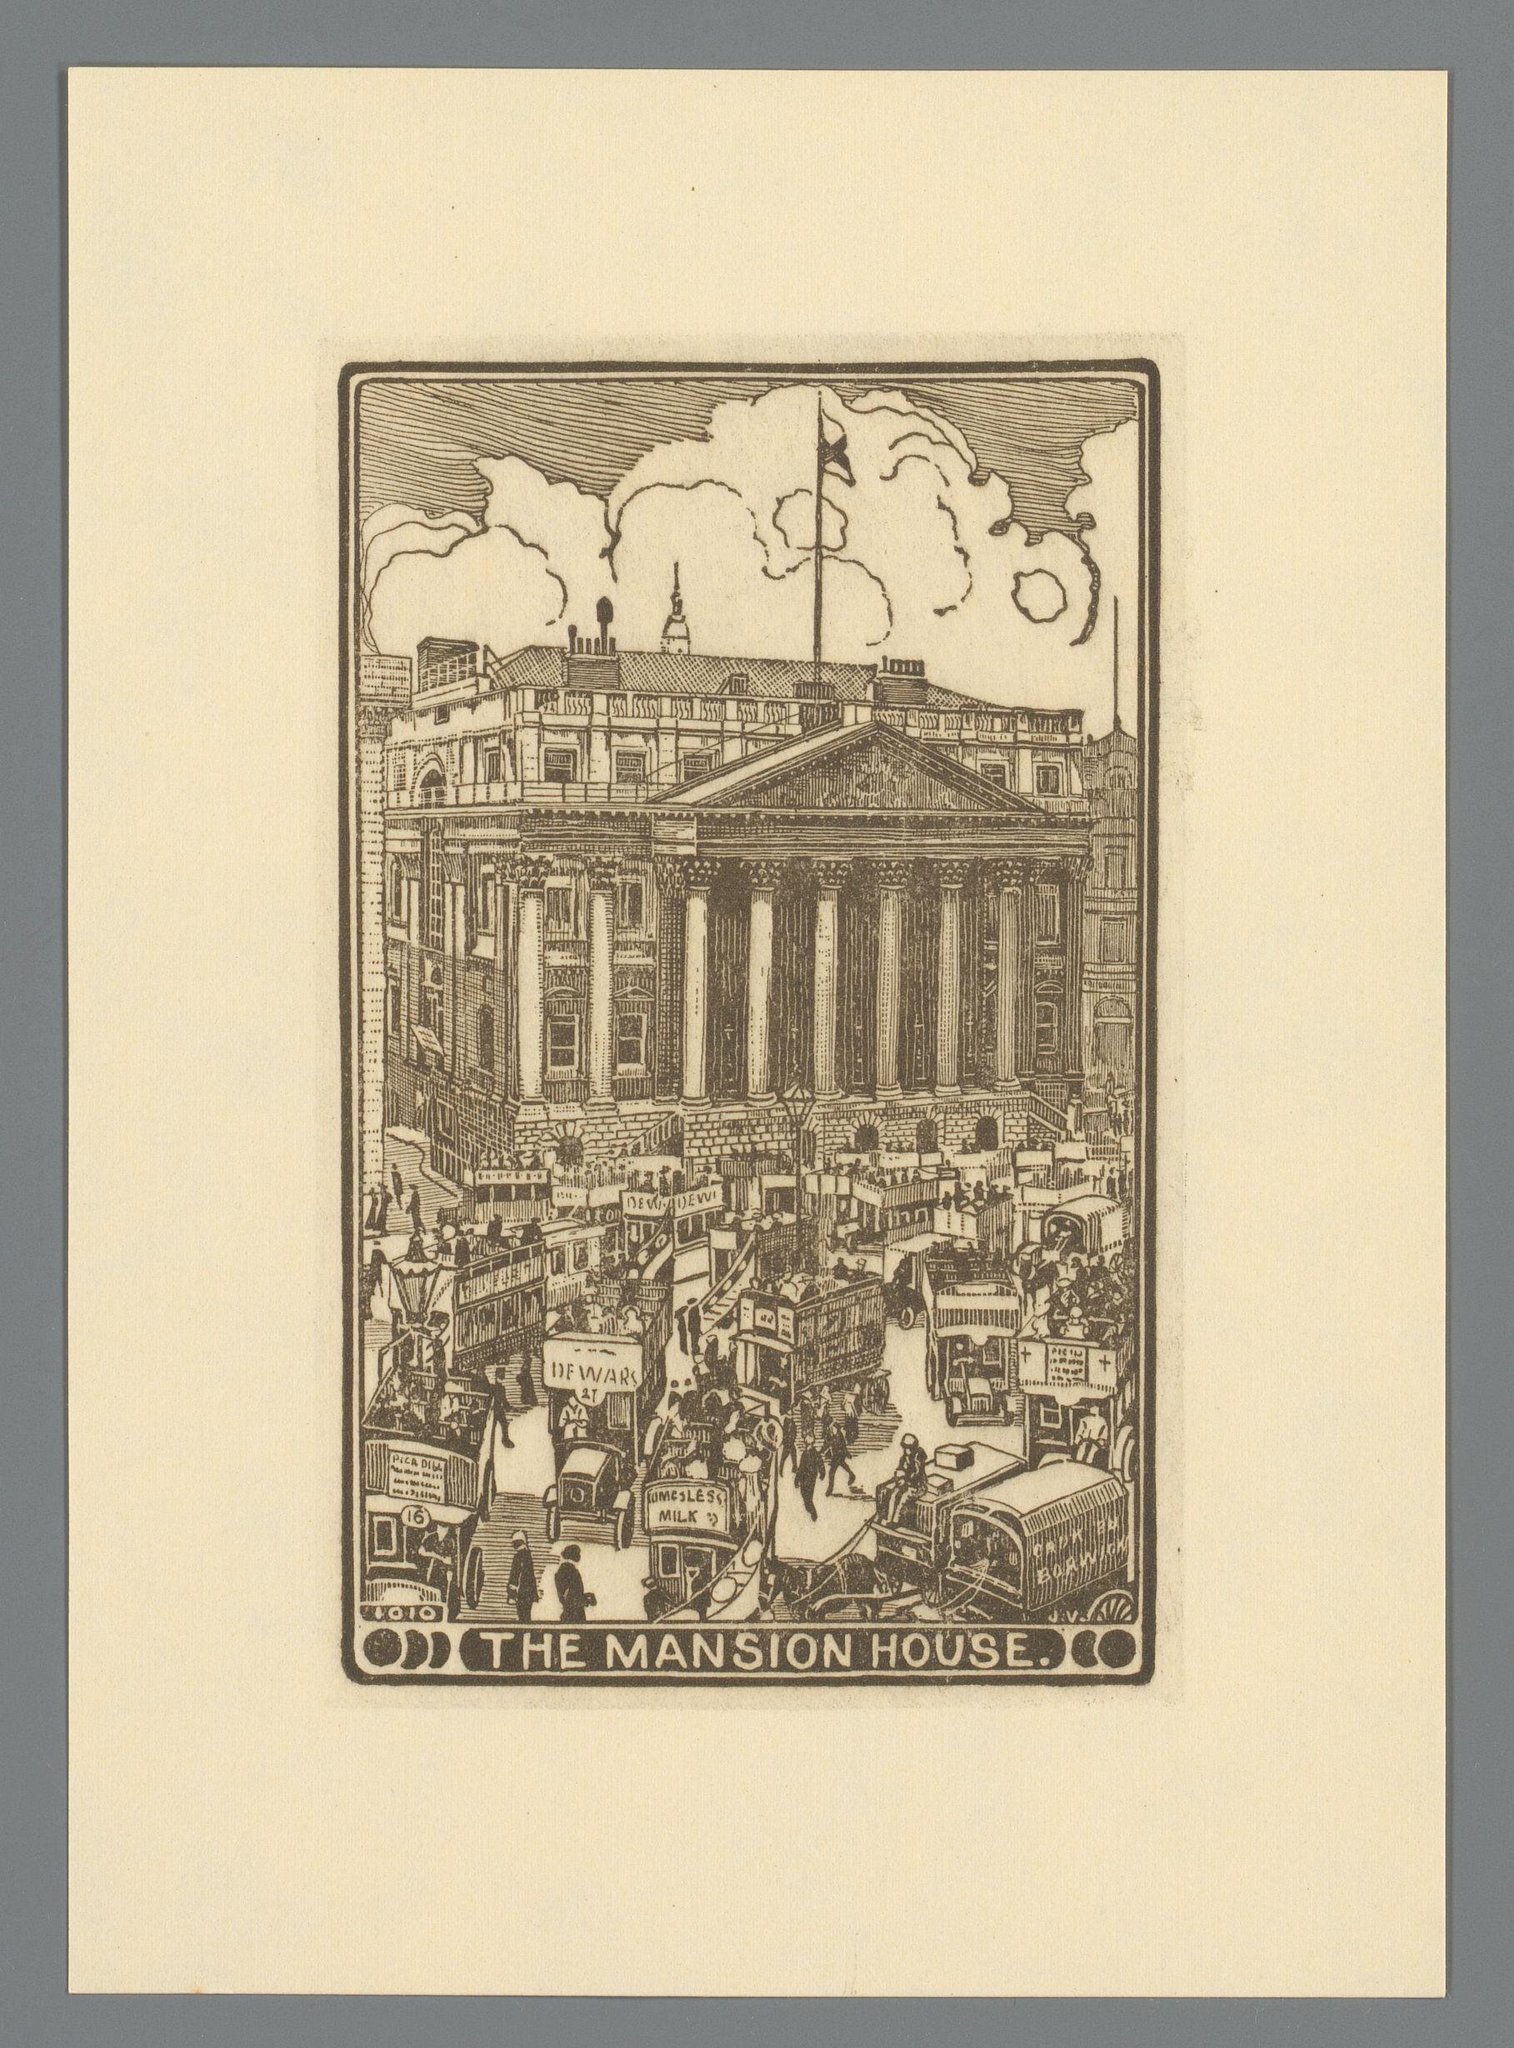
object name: print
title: The Mansion House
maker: Anonymous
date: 1910-1940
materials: paper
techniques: woodcut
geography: netherlands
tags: public road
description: Gezicht op The Mansion House in Londen, met verkeerschaos. Linksonder genummerd: 1010. Losse prent in de folder voor de verkoopexpositie 'Houtsneden door Hollandsche artisten' bij Kunsthandel W. Volmer in Hilversum.